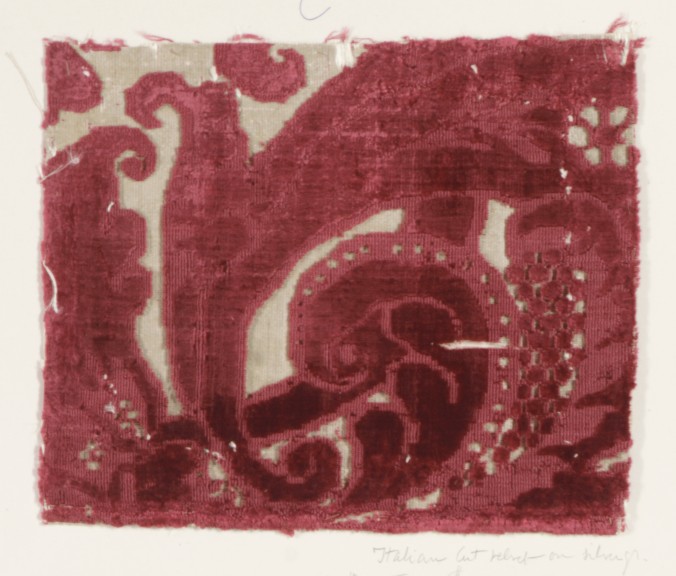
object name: fragment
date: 1601-1700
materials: silk